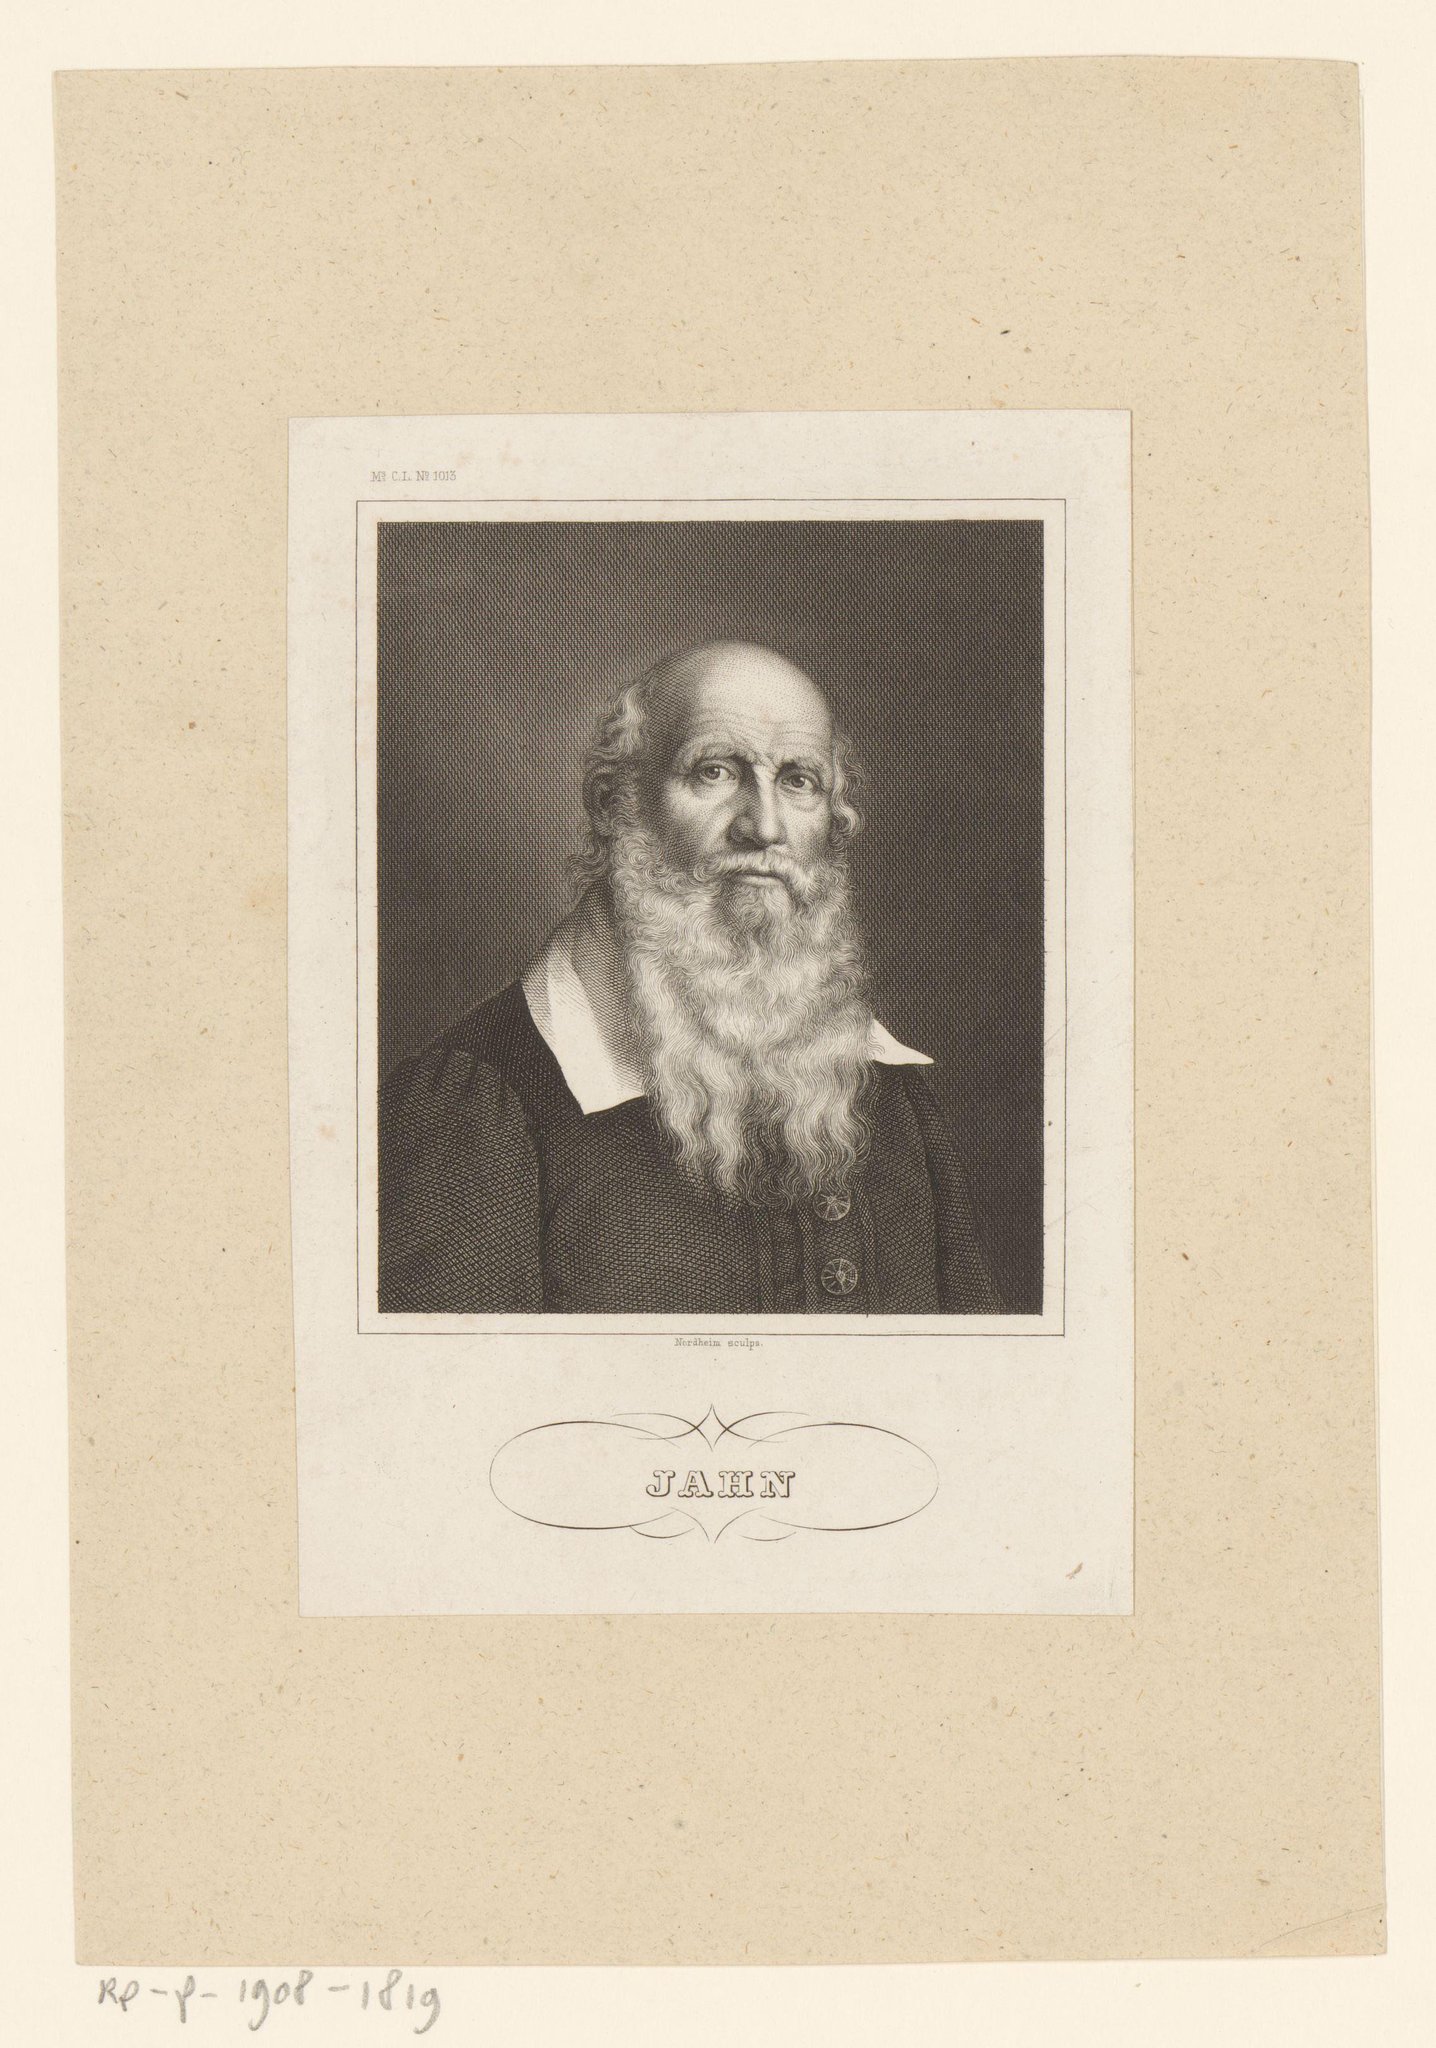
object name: book illustration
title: Portret van Friedrich Ludwig Jahn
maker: johann georg nordheim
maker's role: print maker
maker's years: 1804-1853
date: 1840-1855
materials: paper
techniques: engraving, etching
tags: germany, historical persons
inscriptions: collector's mark: Lugt 2228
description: Prent afkomstig uit: Conversations-Lexikon für die gebildeten Stände, voor het eerst uitgegeven tussen 1840-1855.